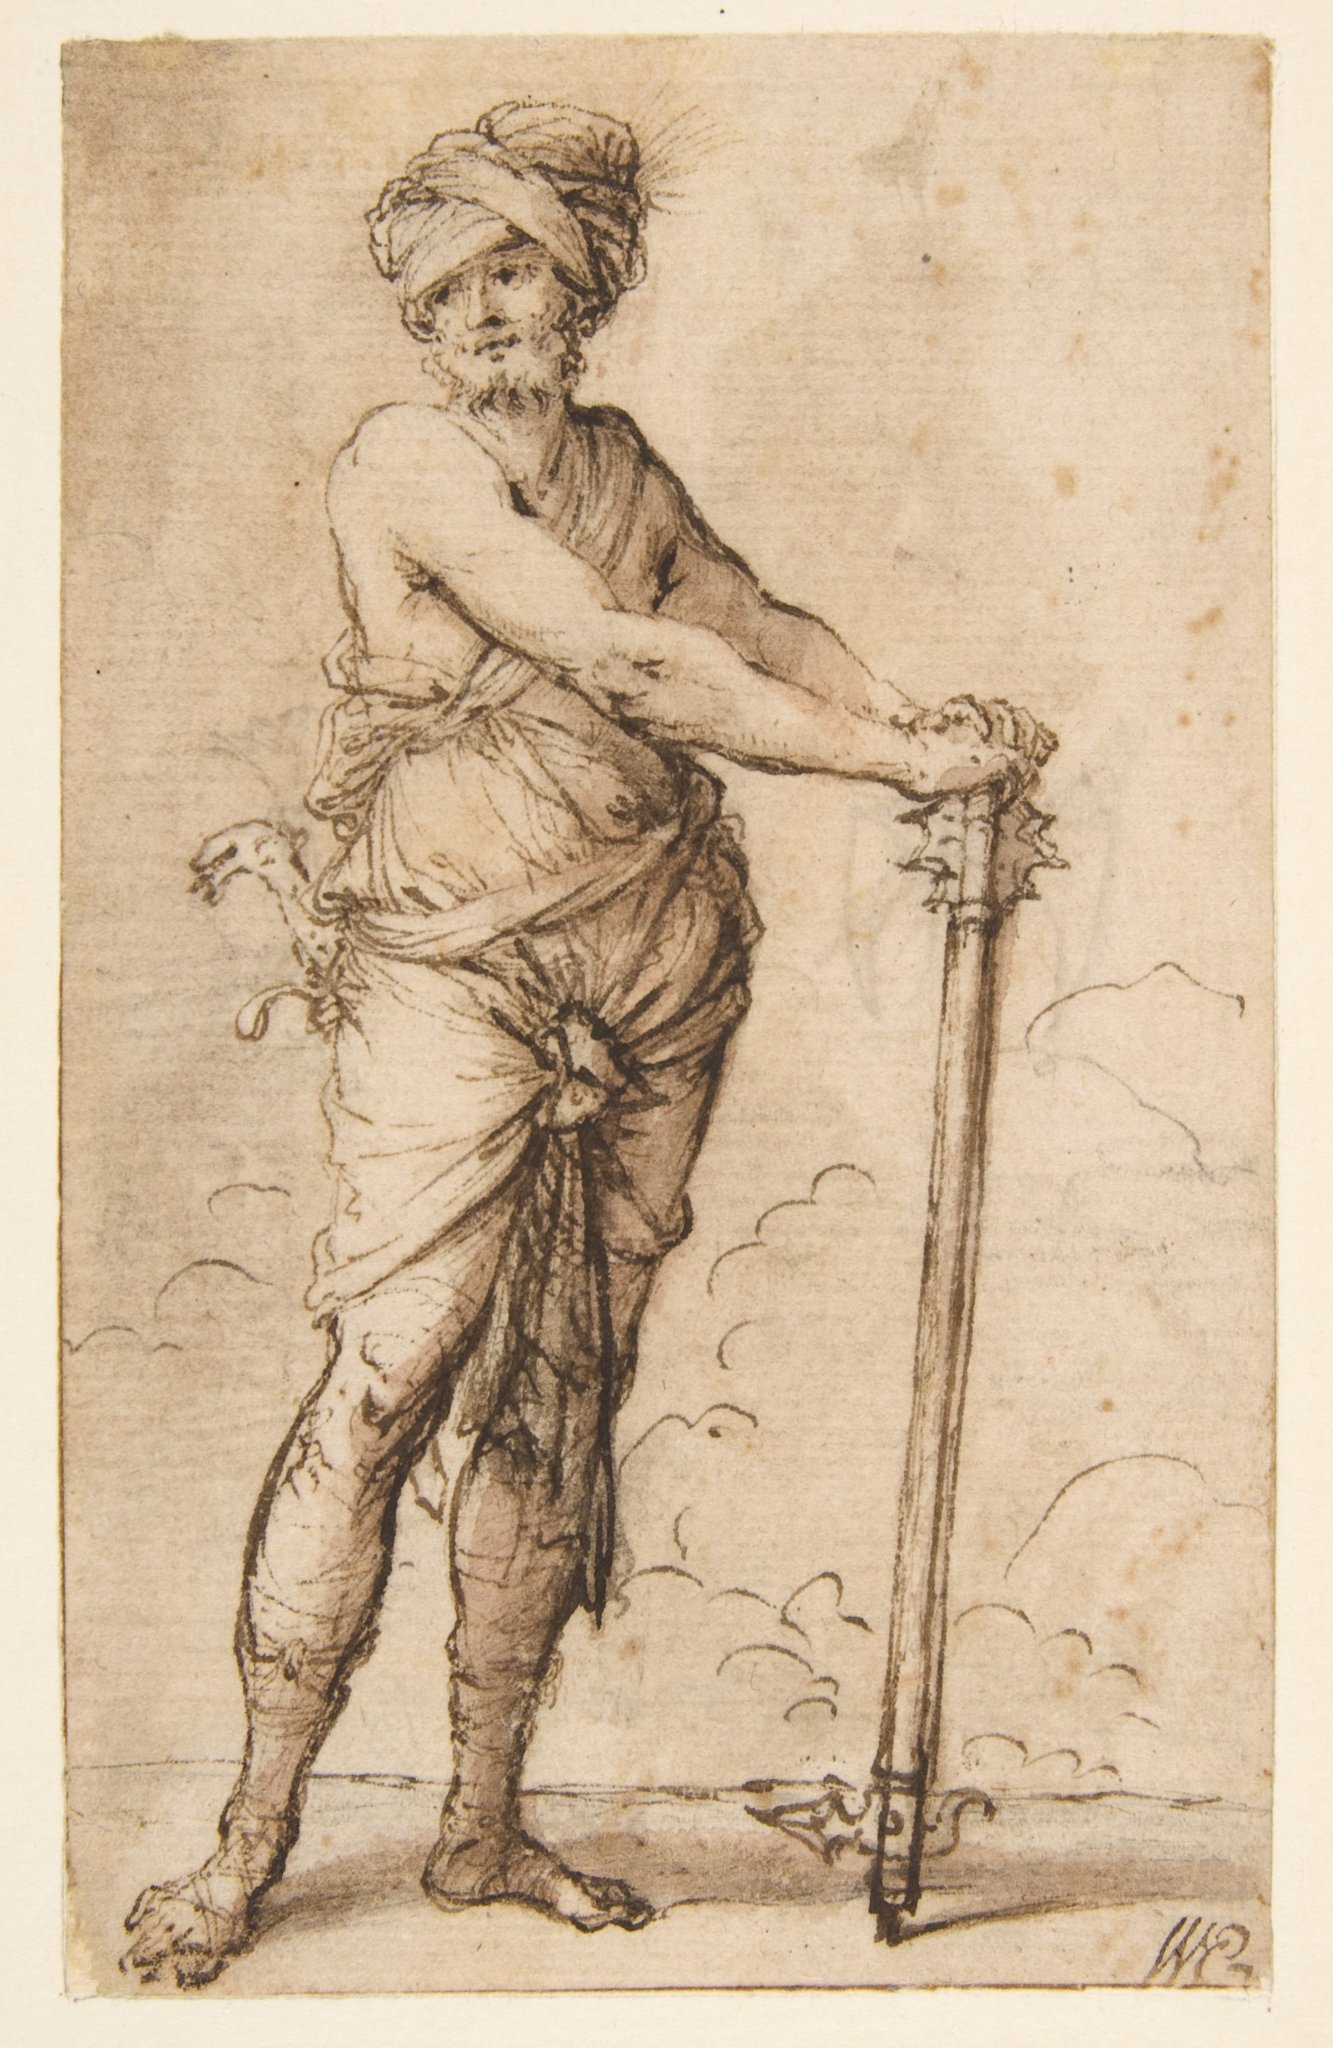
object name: drawing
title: Turbaned Warrior Holding a Mace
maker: salvator rosa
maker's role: artist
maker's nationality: italian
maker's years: 1615-1673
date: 1615-1673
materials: chalk, ink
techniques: pen, wash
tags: weapons,men